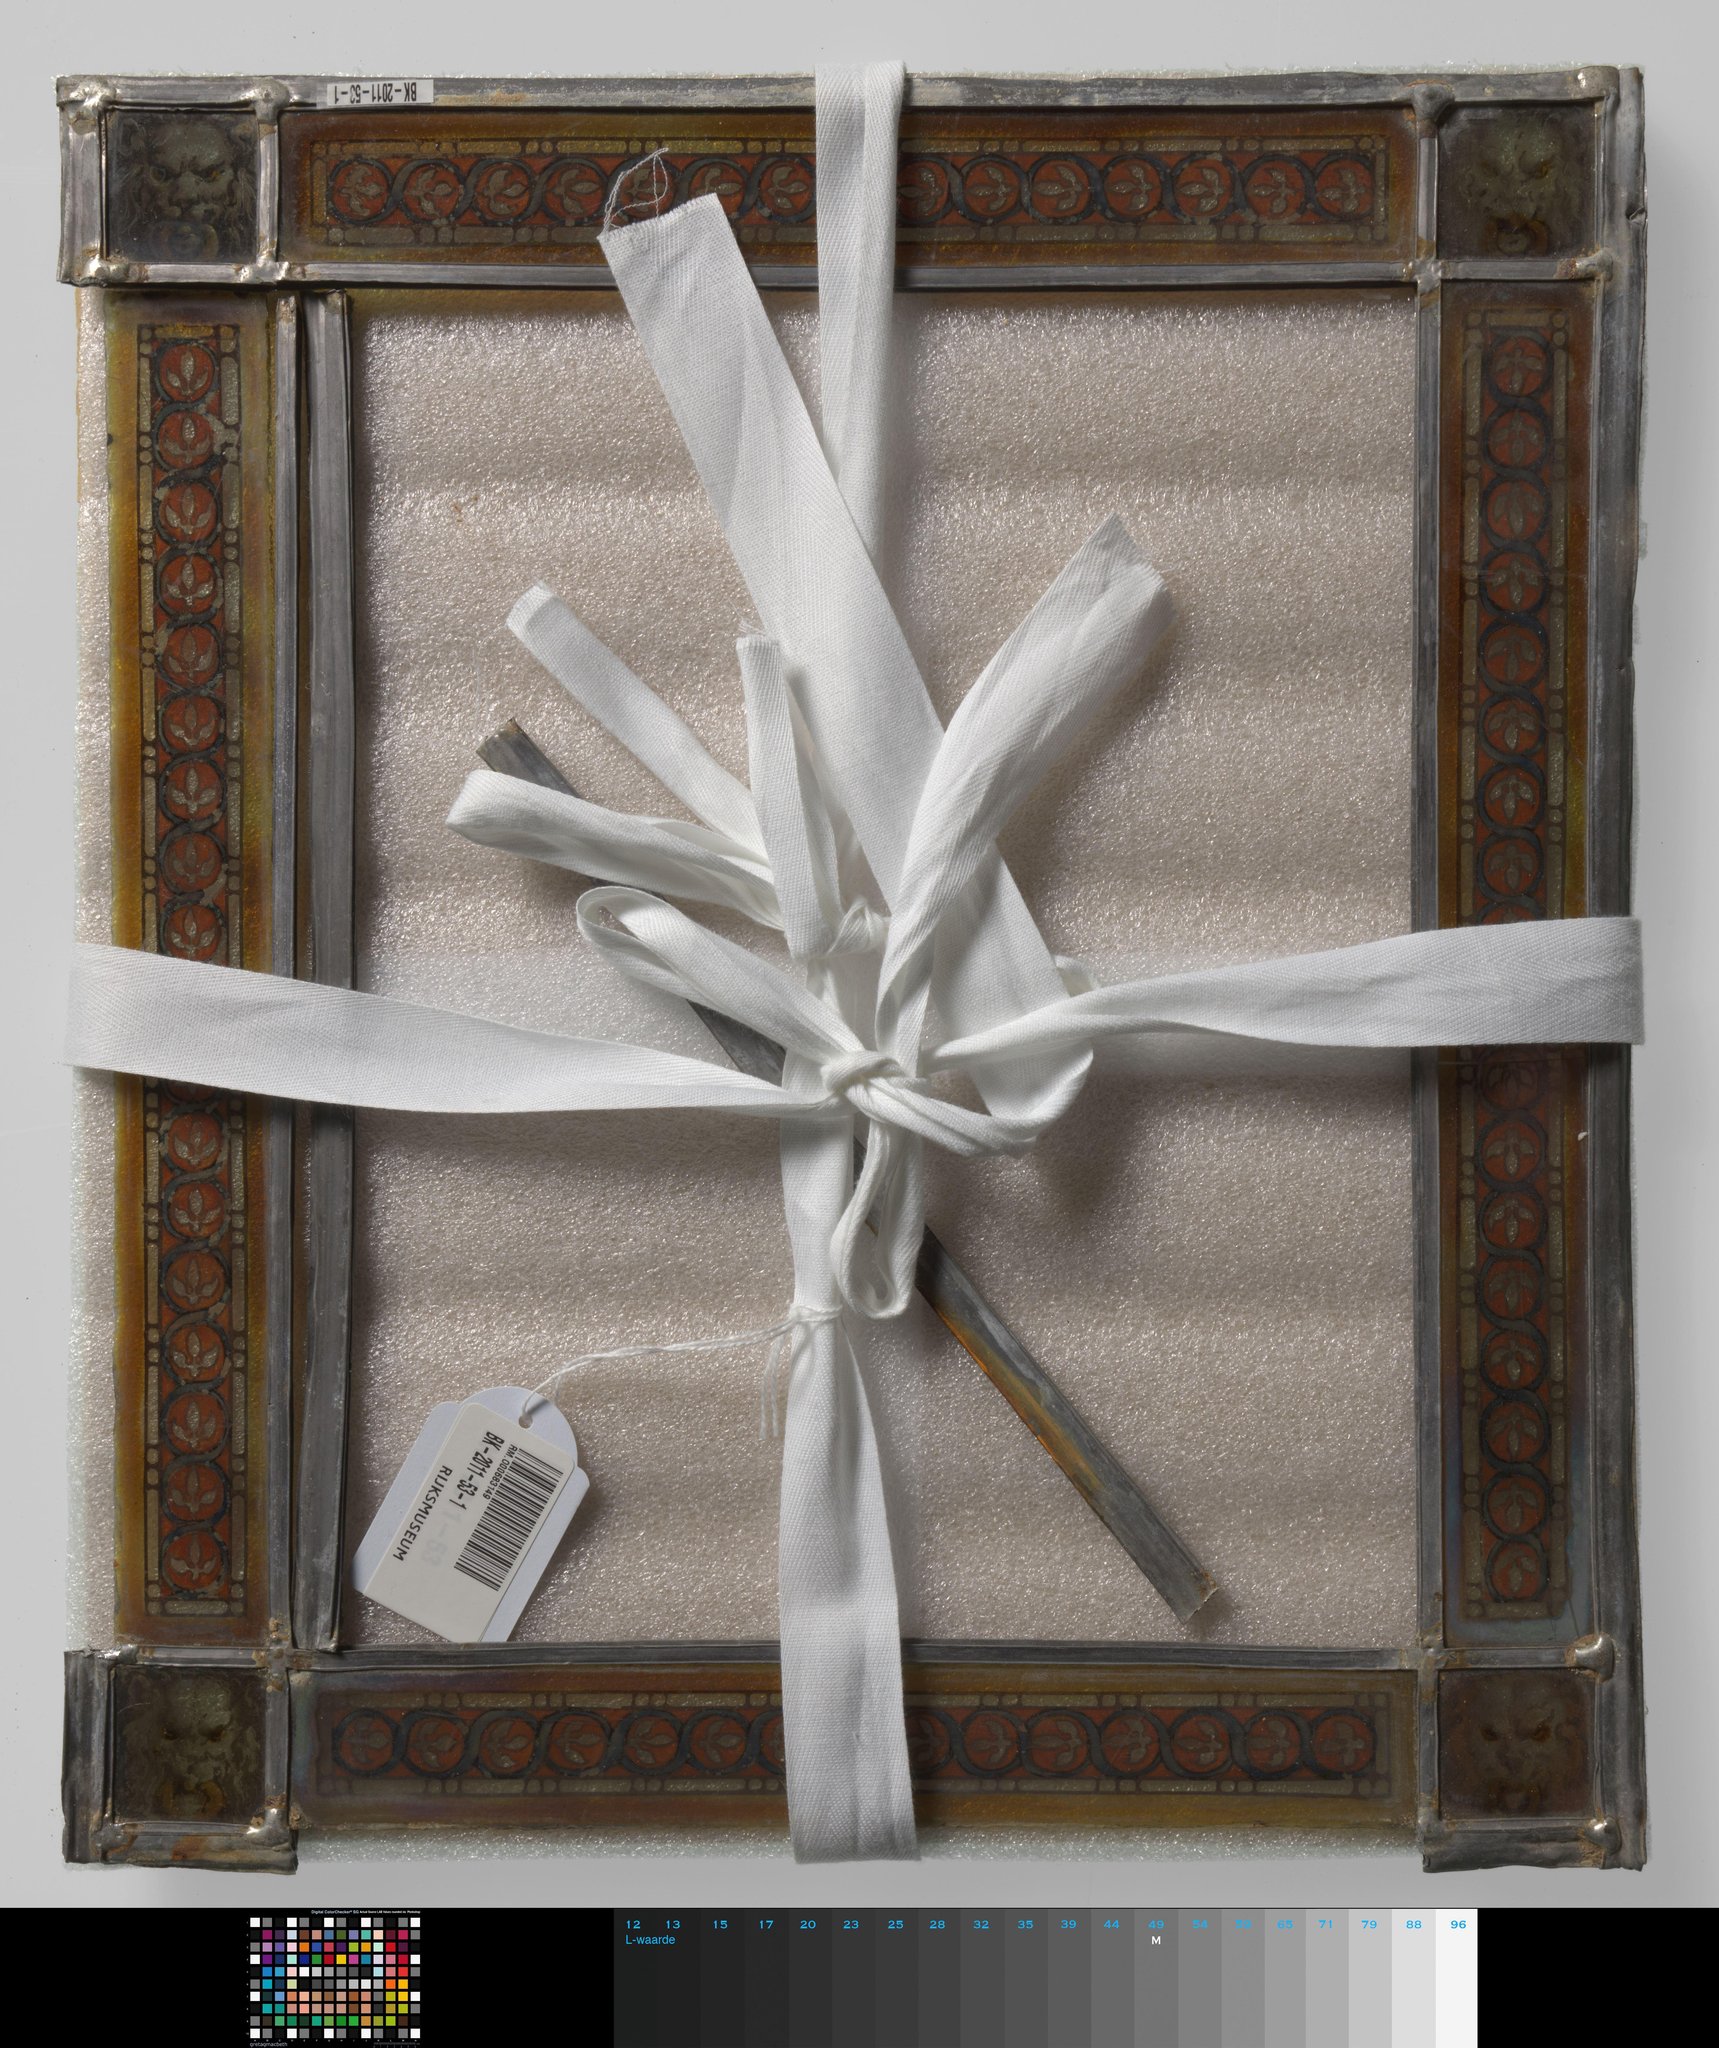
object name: light window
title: Lijst van Aritmetica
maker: jacques de gheyn (i)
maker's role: draughtsman, print maker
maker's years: 1537-1581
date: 1565-1582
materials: glass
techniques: enamel painting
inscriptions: monogram: ‘IvdG’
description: De ruit is gevat in een 19de-eeuwse glas-omlijsting. Deze omlijsting toont in de vier hoeken leeuwenkoppen.